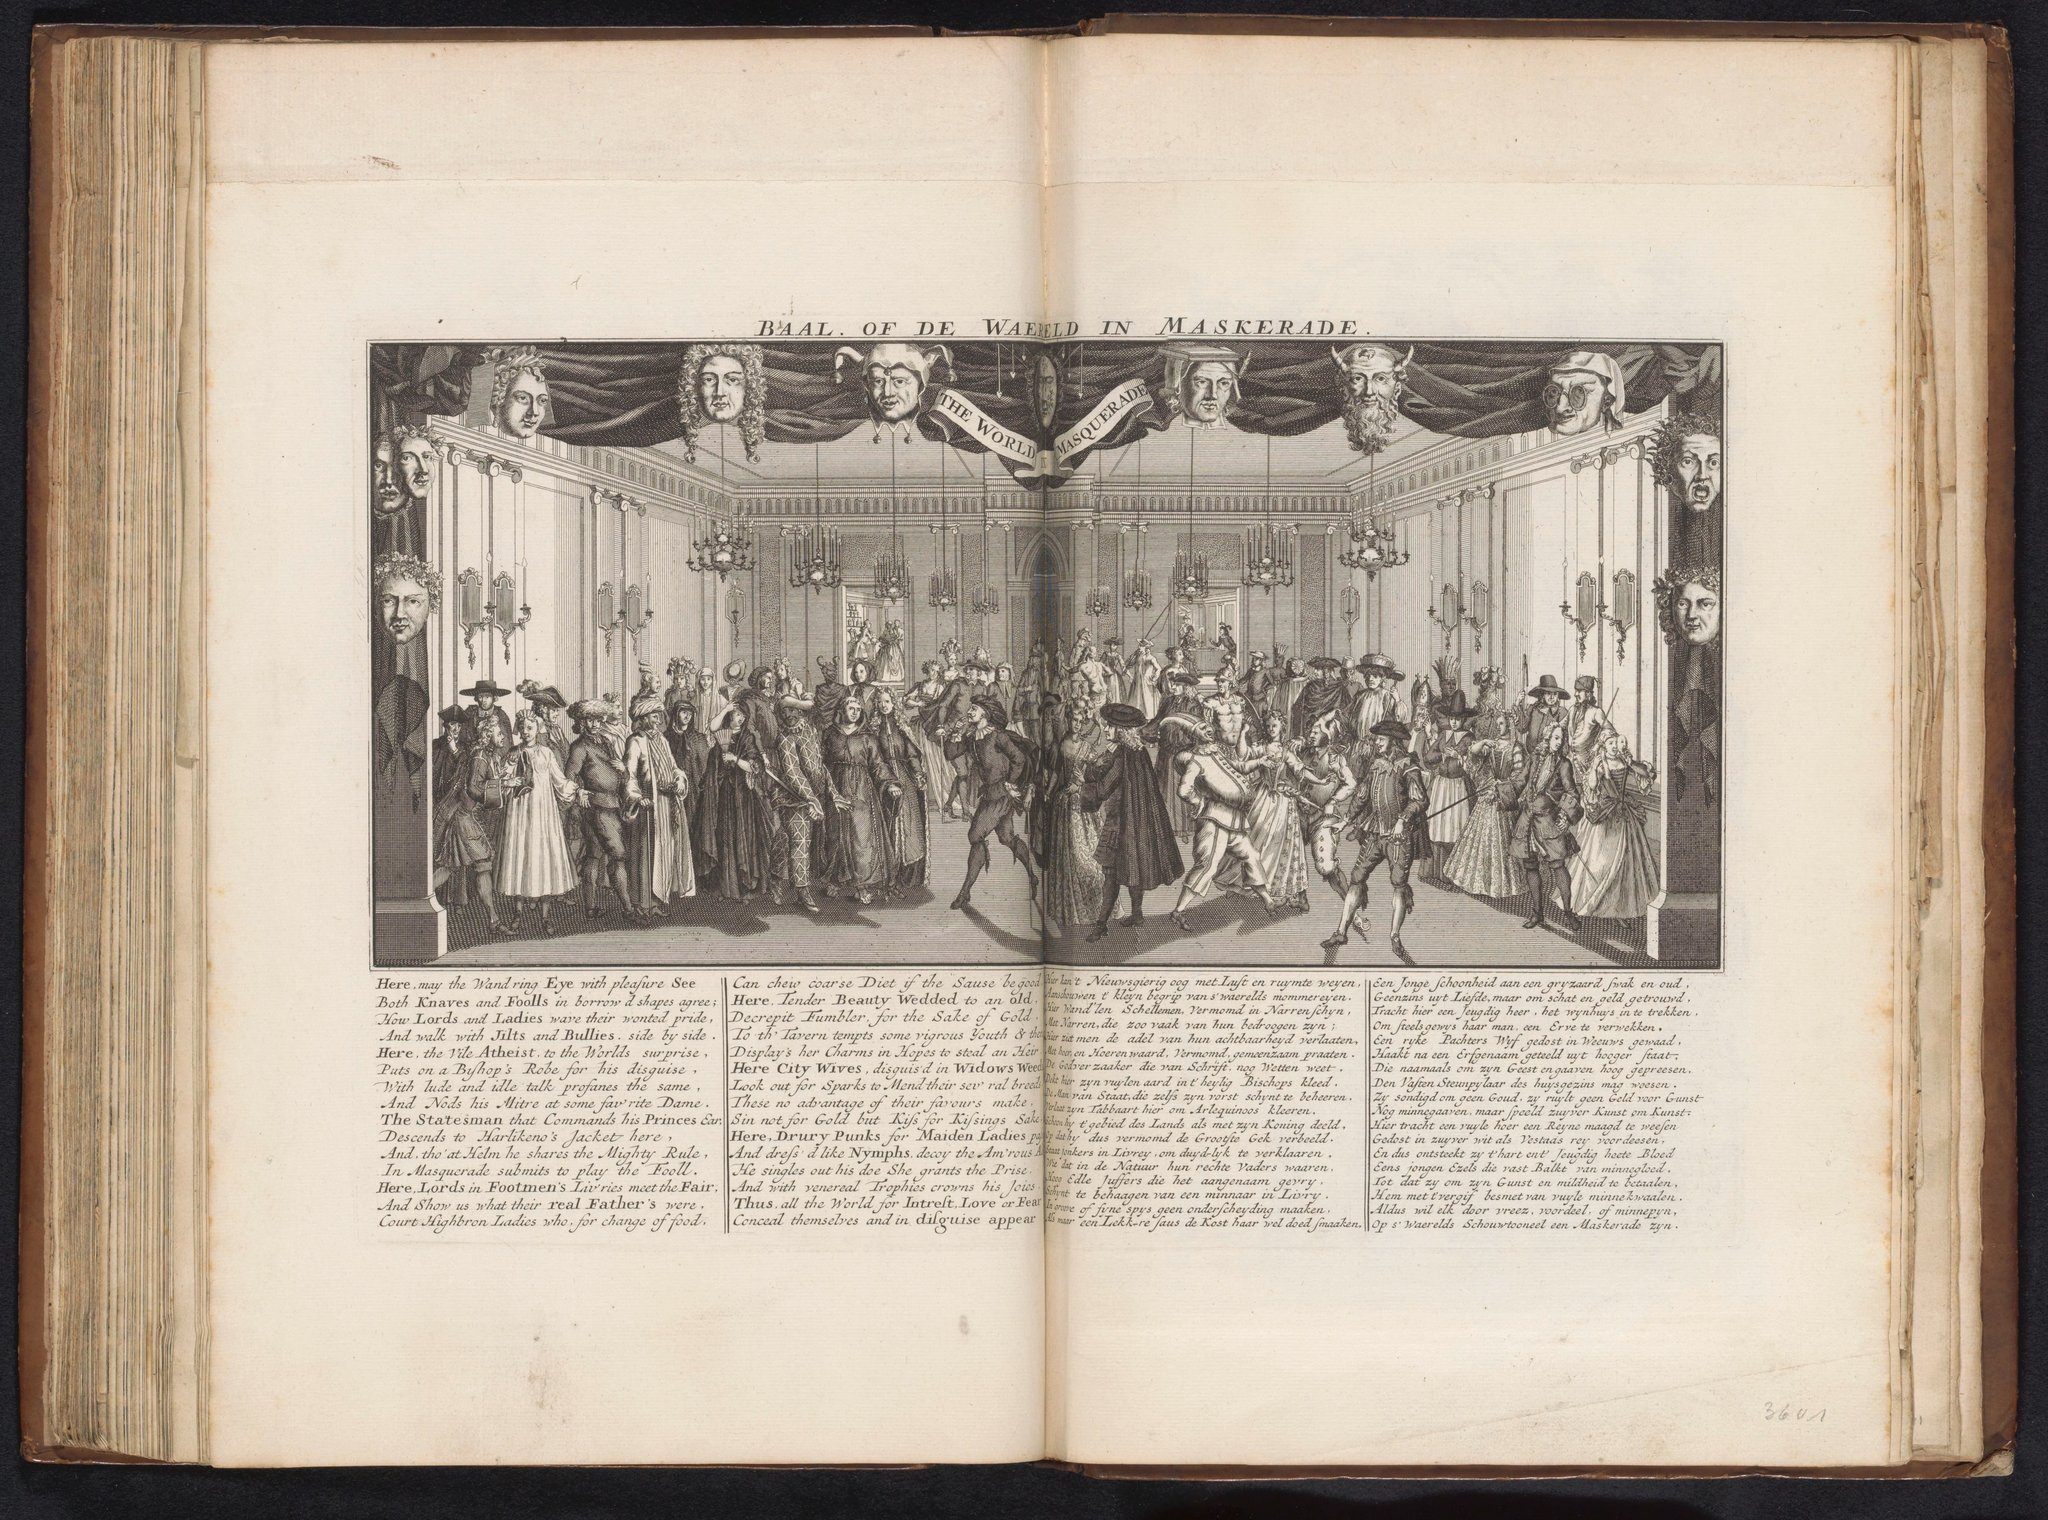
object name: cartoon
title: Het Groote Tafereel der Dwaasheid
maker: Anonymous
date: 1720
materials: paper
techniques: engraving, etching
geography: northern netherlands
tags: masquerade, masked ball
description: Bal, of de Wereld in Maskerade. Toneel met een danszaal waarin een gemaskerd bal gevierd wordt. Aan de zijkanten en boven het toneel hangen elf maskers, waaronder die van de duivel, een nar etc. Met onderschrift in vier kolommen in het Engels en Nederlands. Prent in de gebonden eerste uitgave (304 B 11) van Het Groote Tafereel der Dwaasheid met spotprenten op de Windhandel of Actiehandel van 1720.